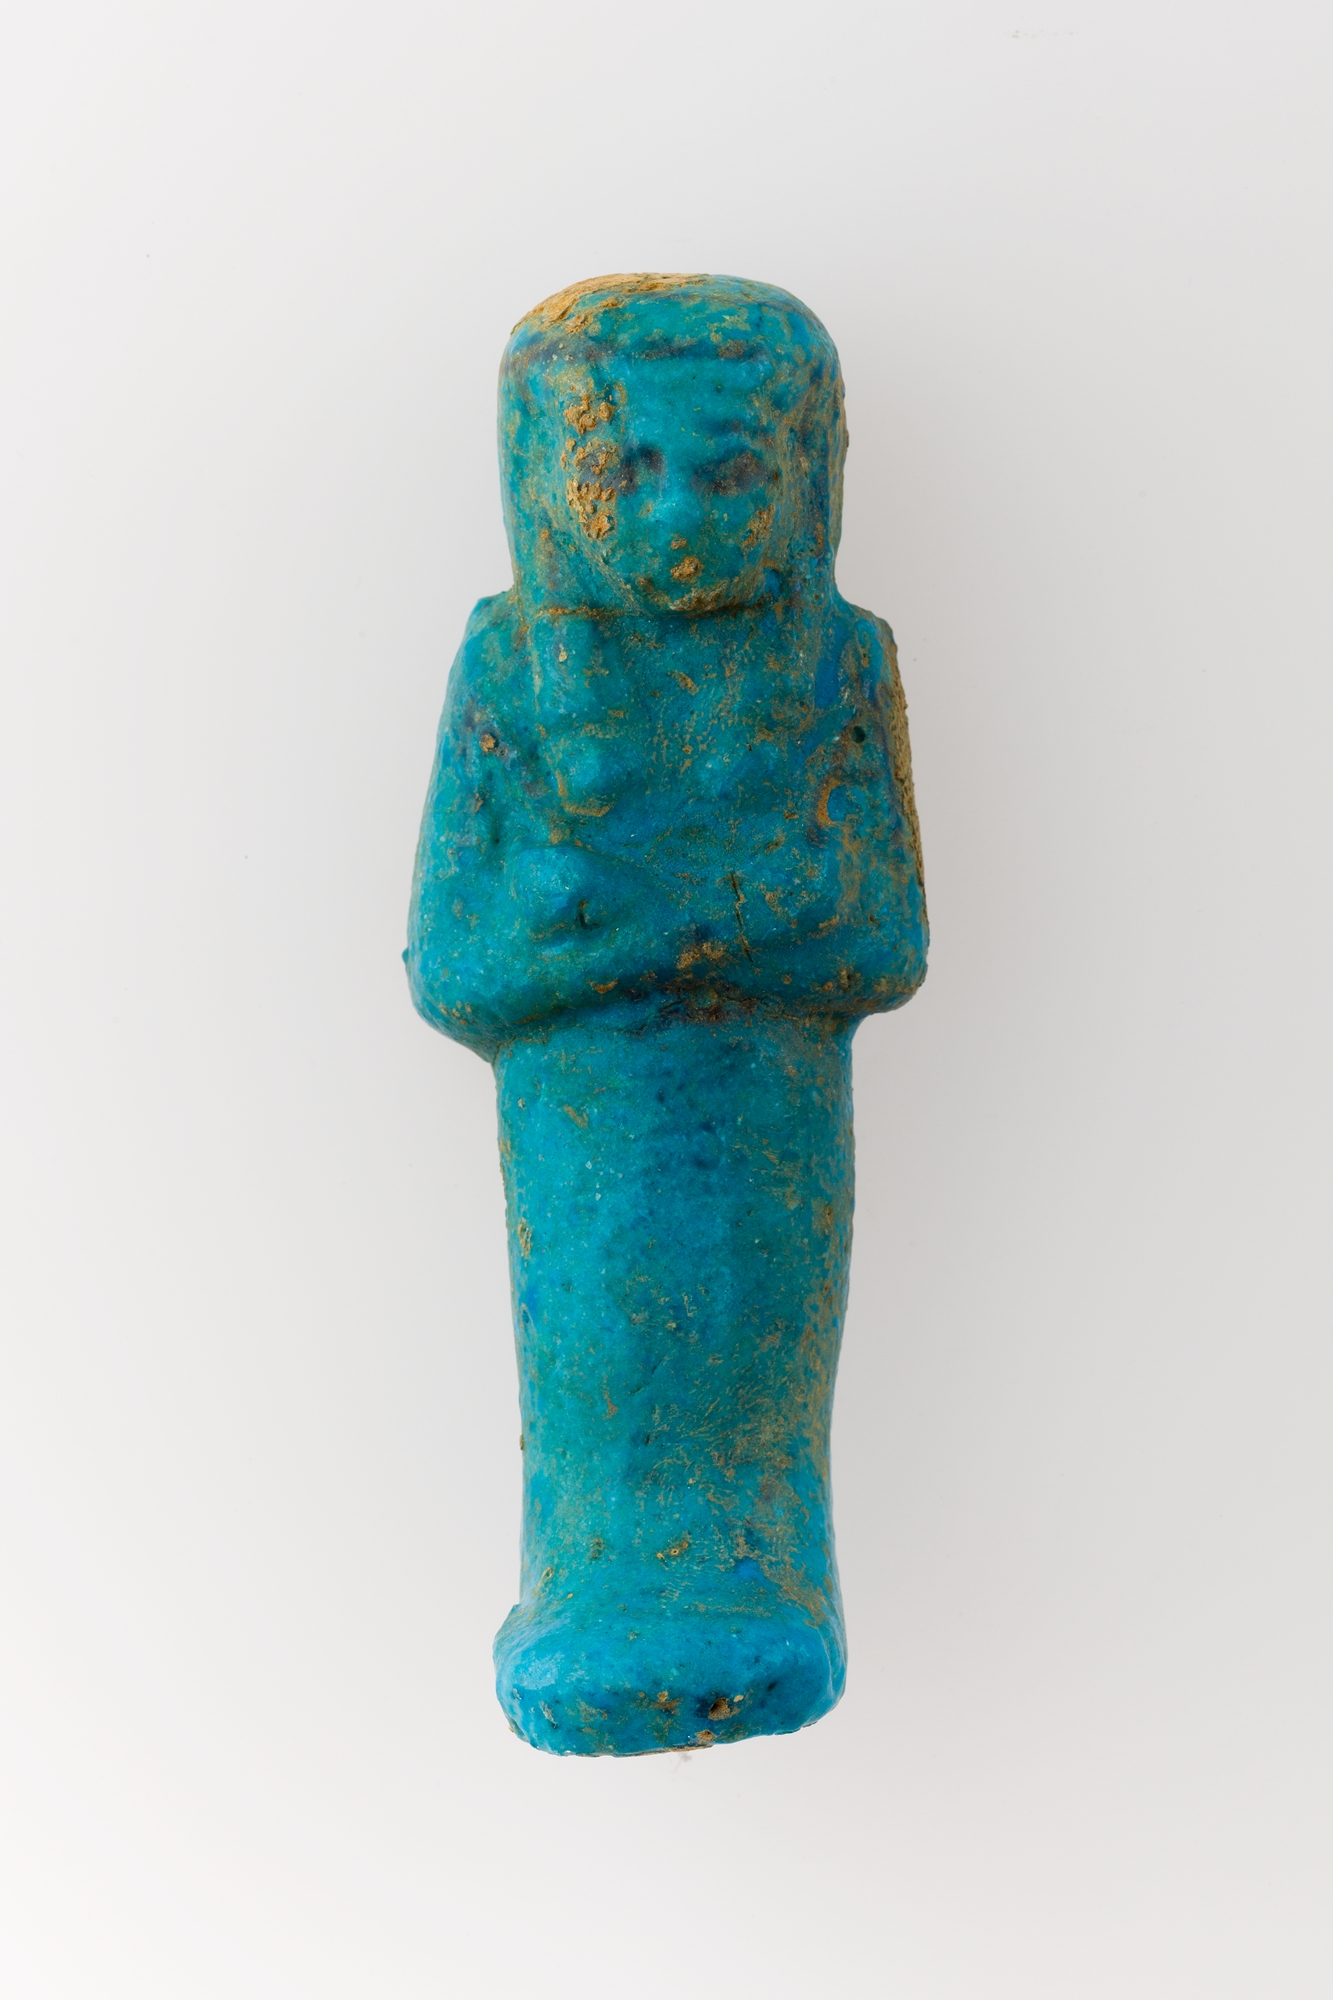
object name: shabti, henettawy c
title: Worker Shabti of Henettawy (C), Daughter of Isetemkheb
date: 990-970 BCE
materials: faience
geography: egypt